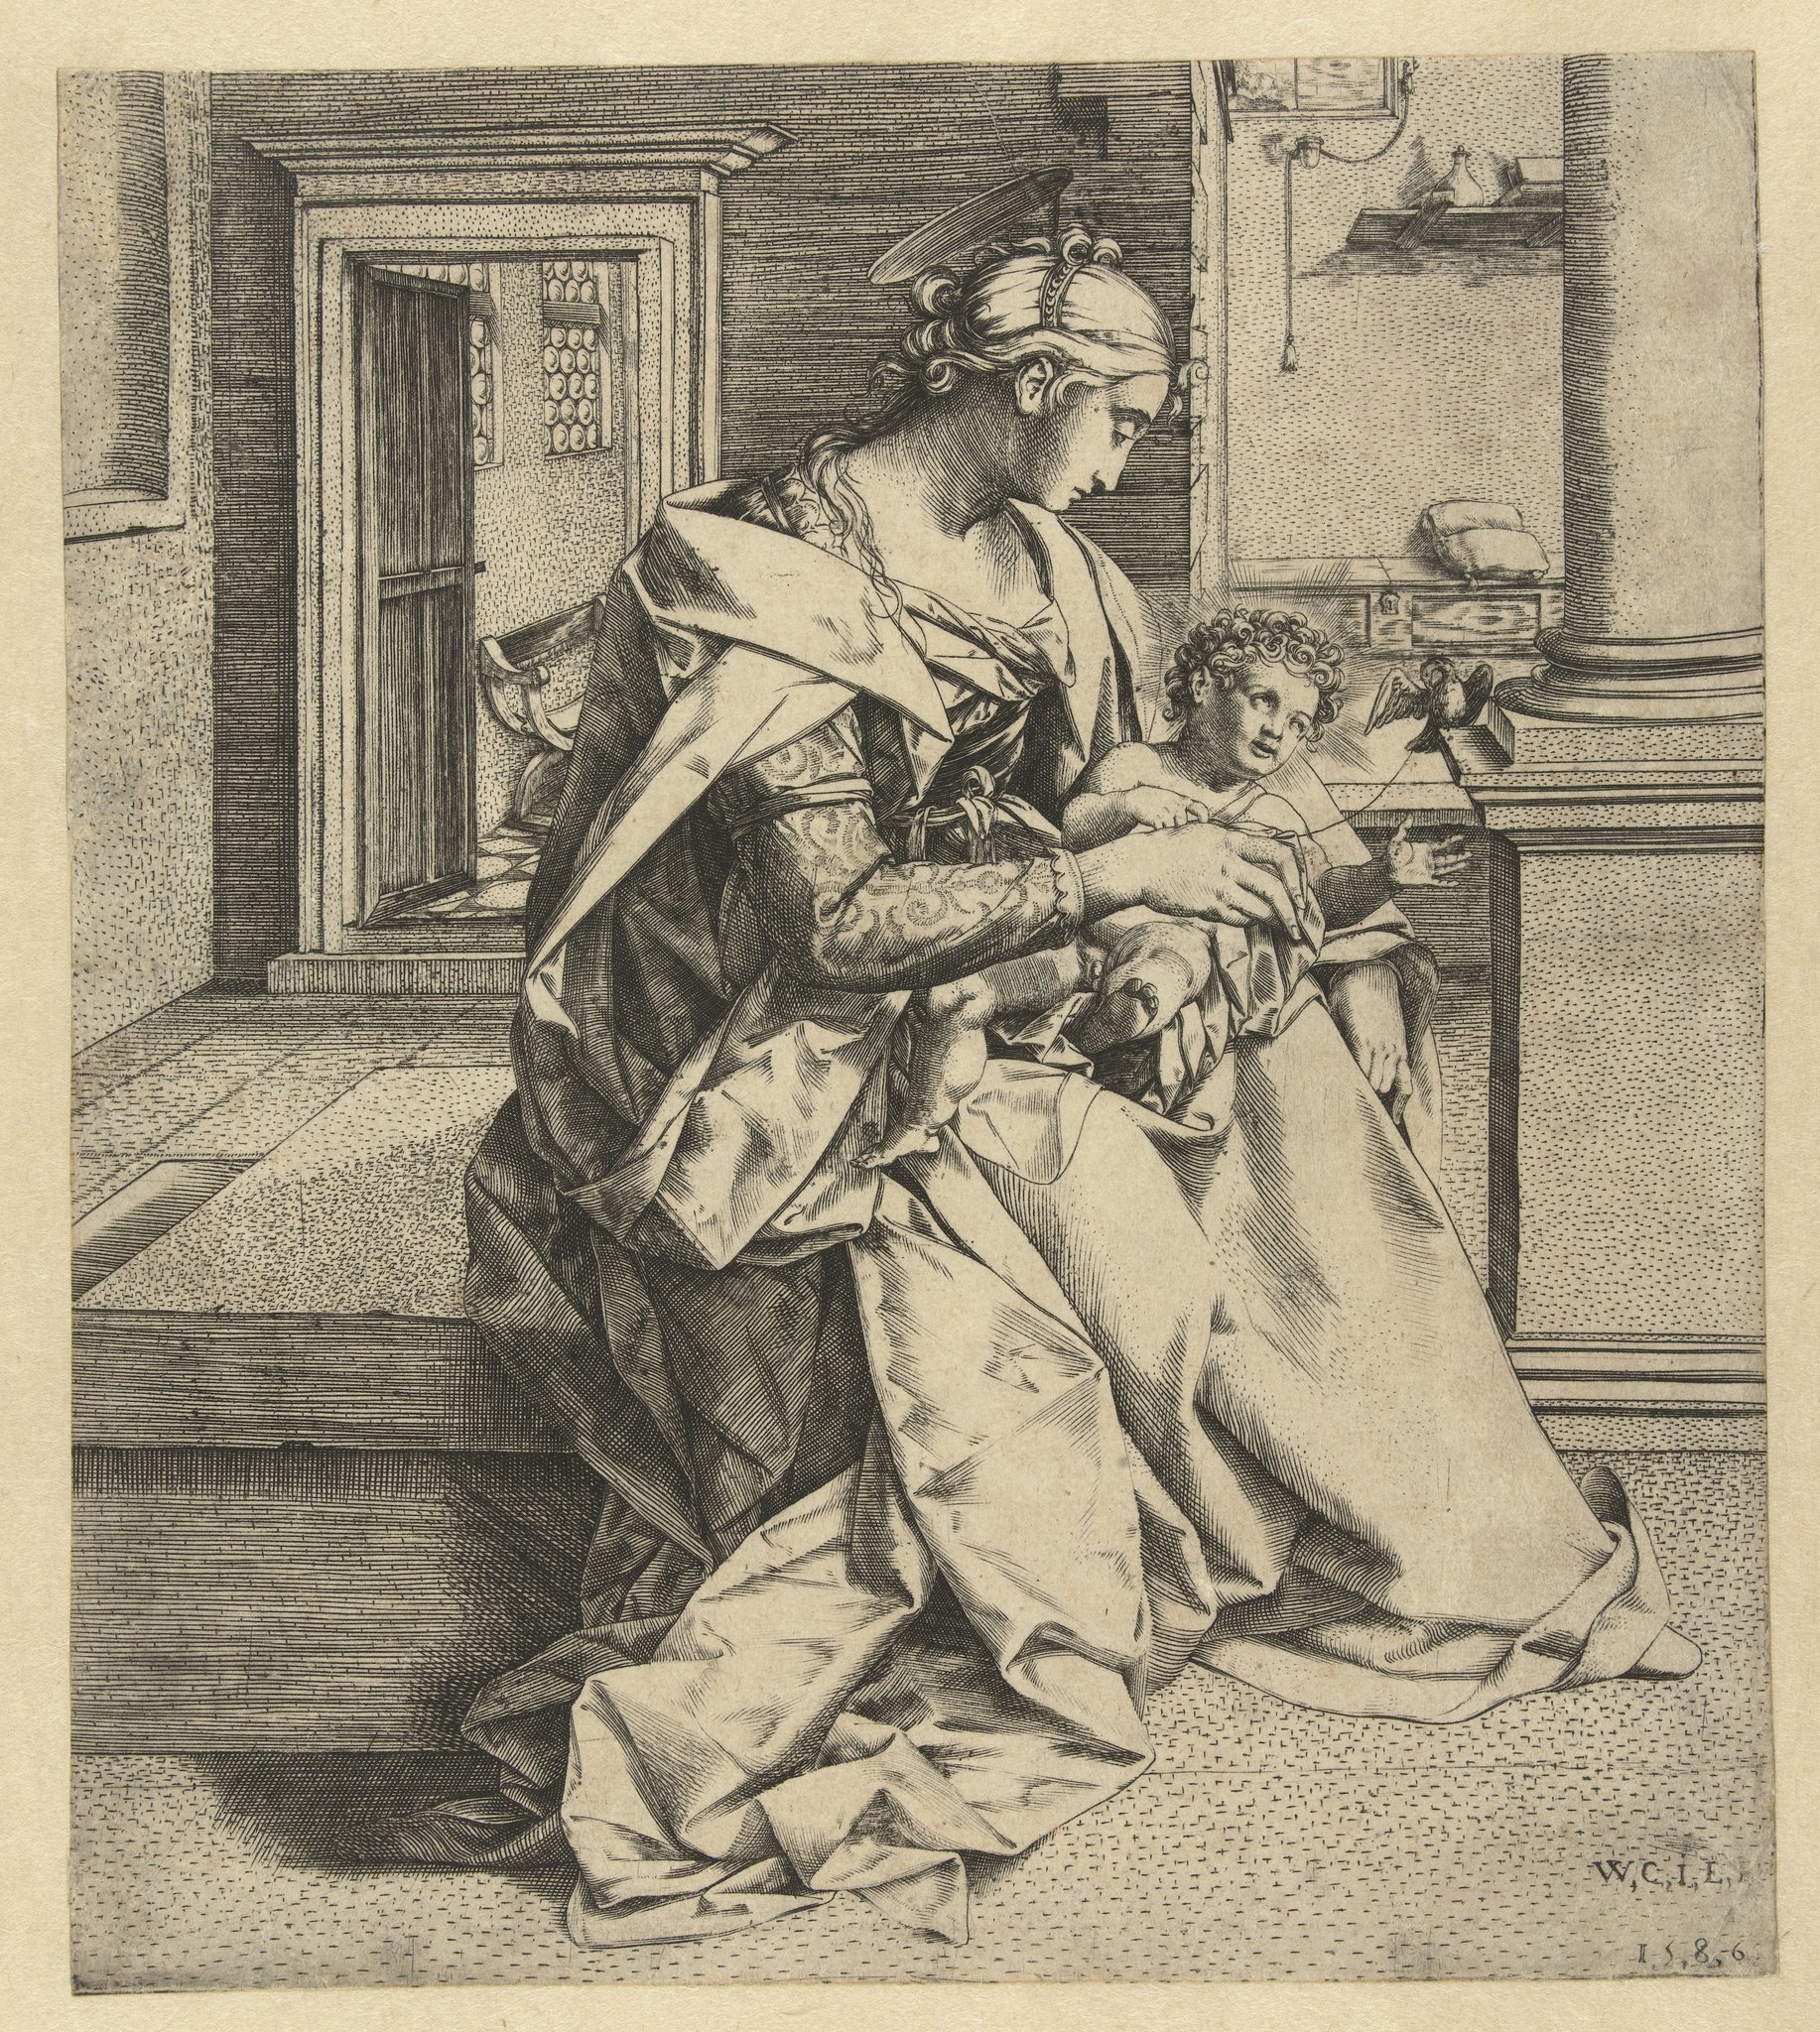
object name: print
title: Madonna met kind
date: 1586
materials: paper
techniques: engraving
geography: low countries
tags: bird on a cord or string, mary sitting or enthroned, the christ-child lying on her knee (christ-child to mary's left)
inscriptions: collector's mark: Lugt 2760, inscription: ‘G. Storck a Milano 1799 In no 10229’, collector's mark: Lugt 2373, collector's mark: Lugt 2228a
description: Maria en Christuskind met vogel aan touwtje gezeten in een hal.